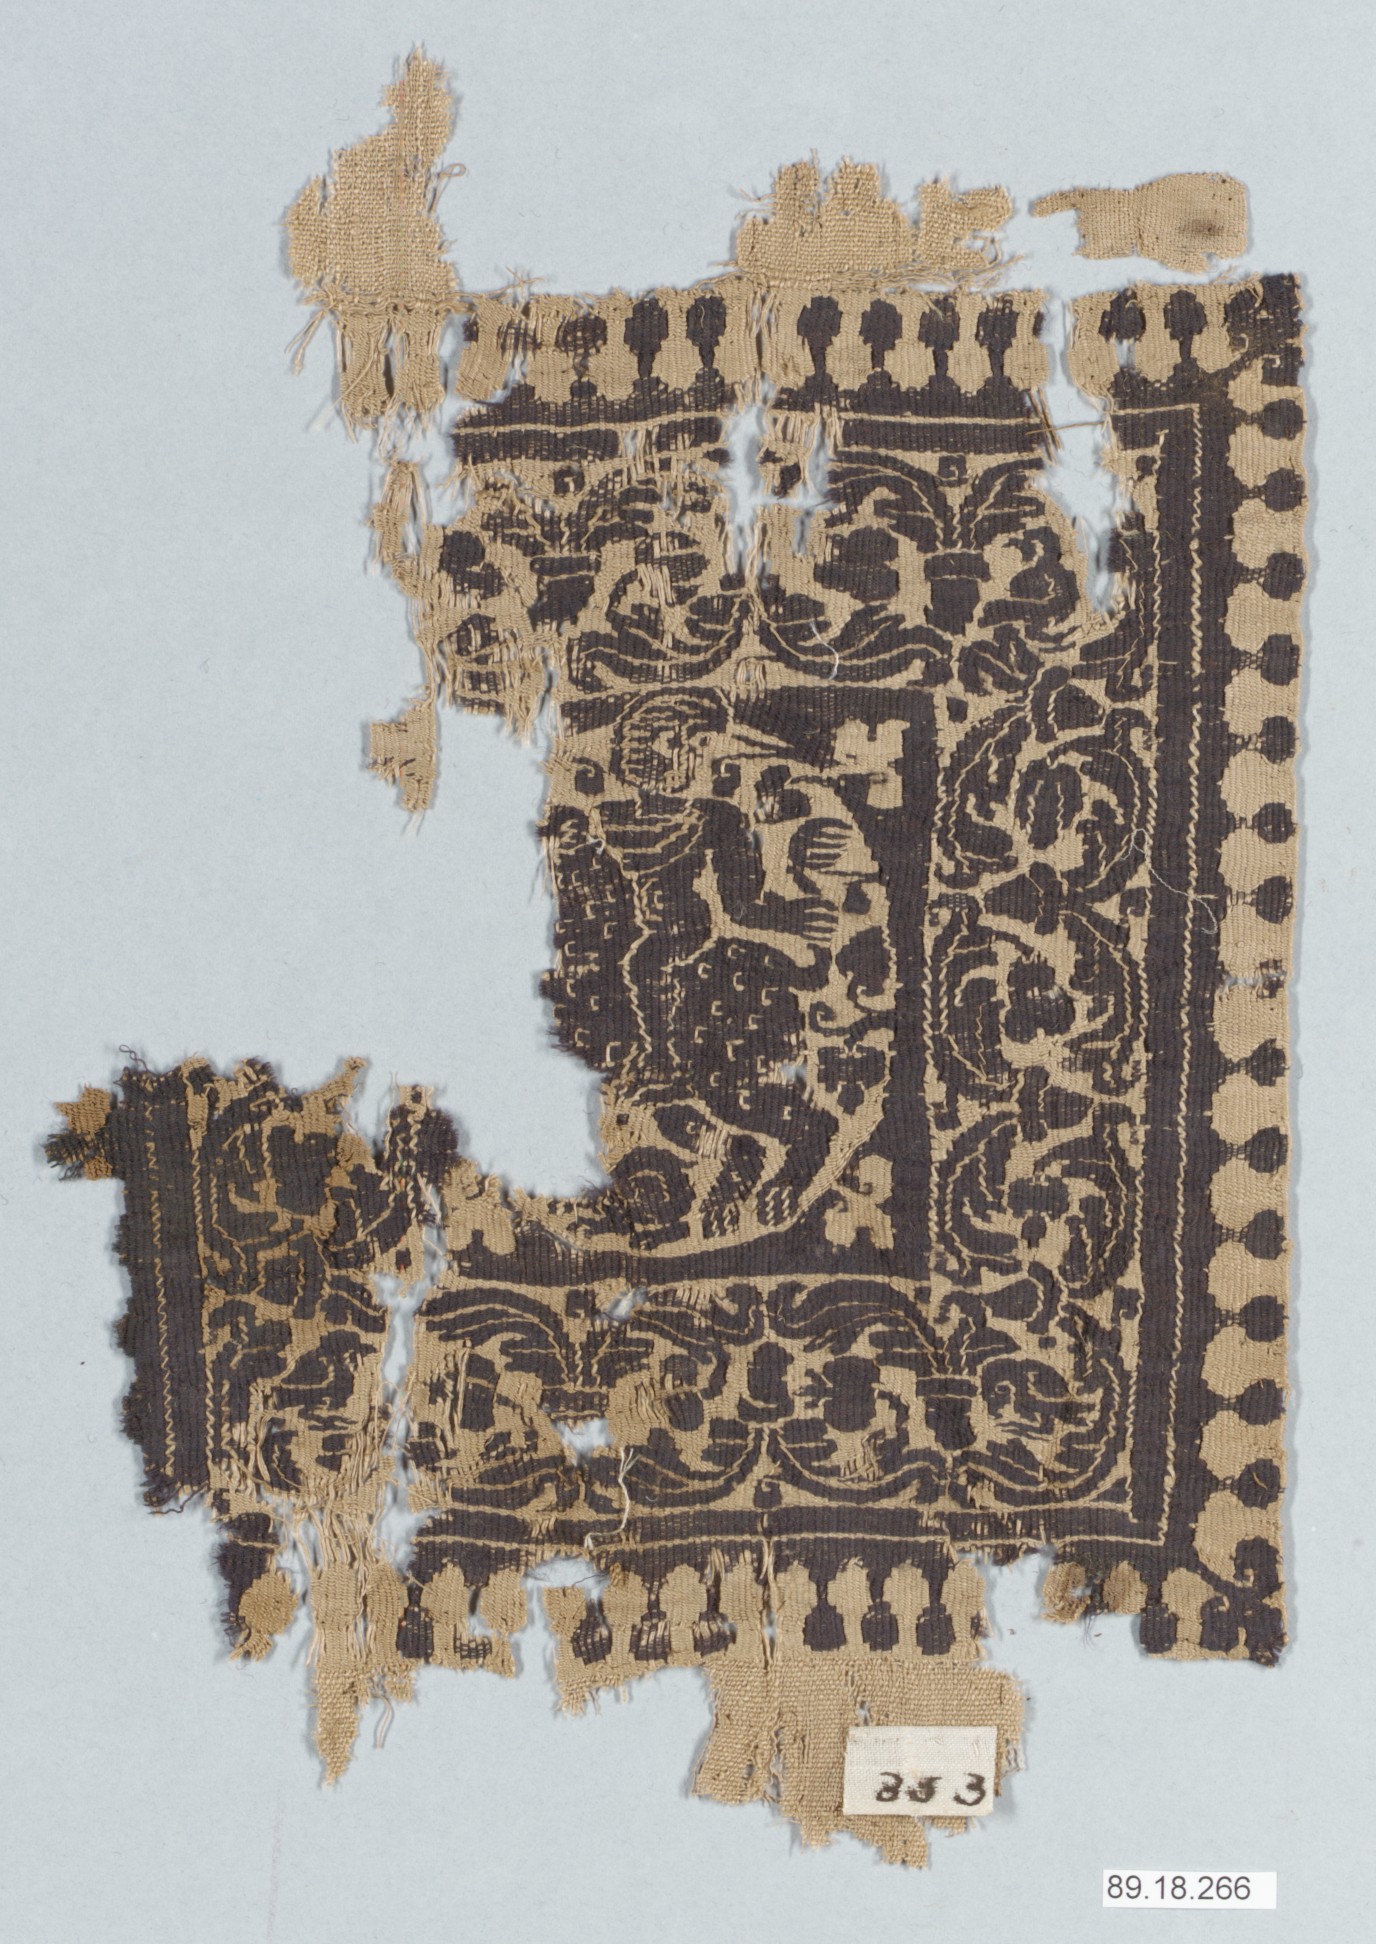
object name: textile fragment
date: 201-400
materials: linen, wool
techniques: weave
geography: egypt